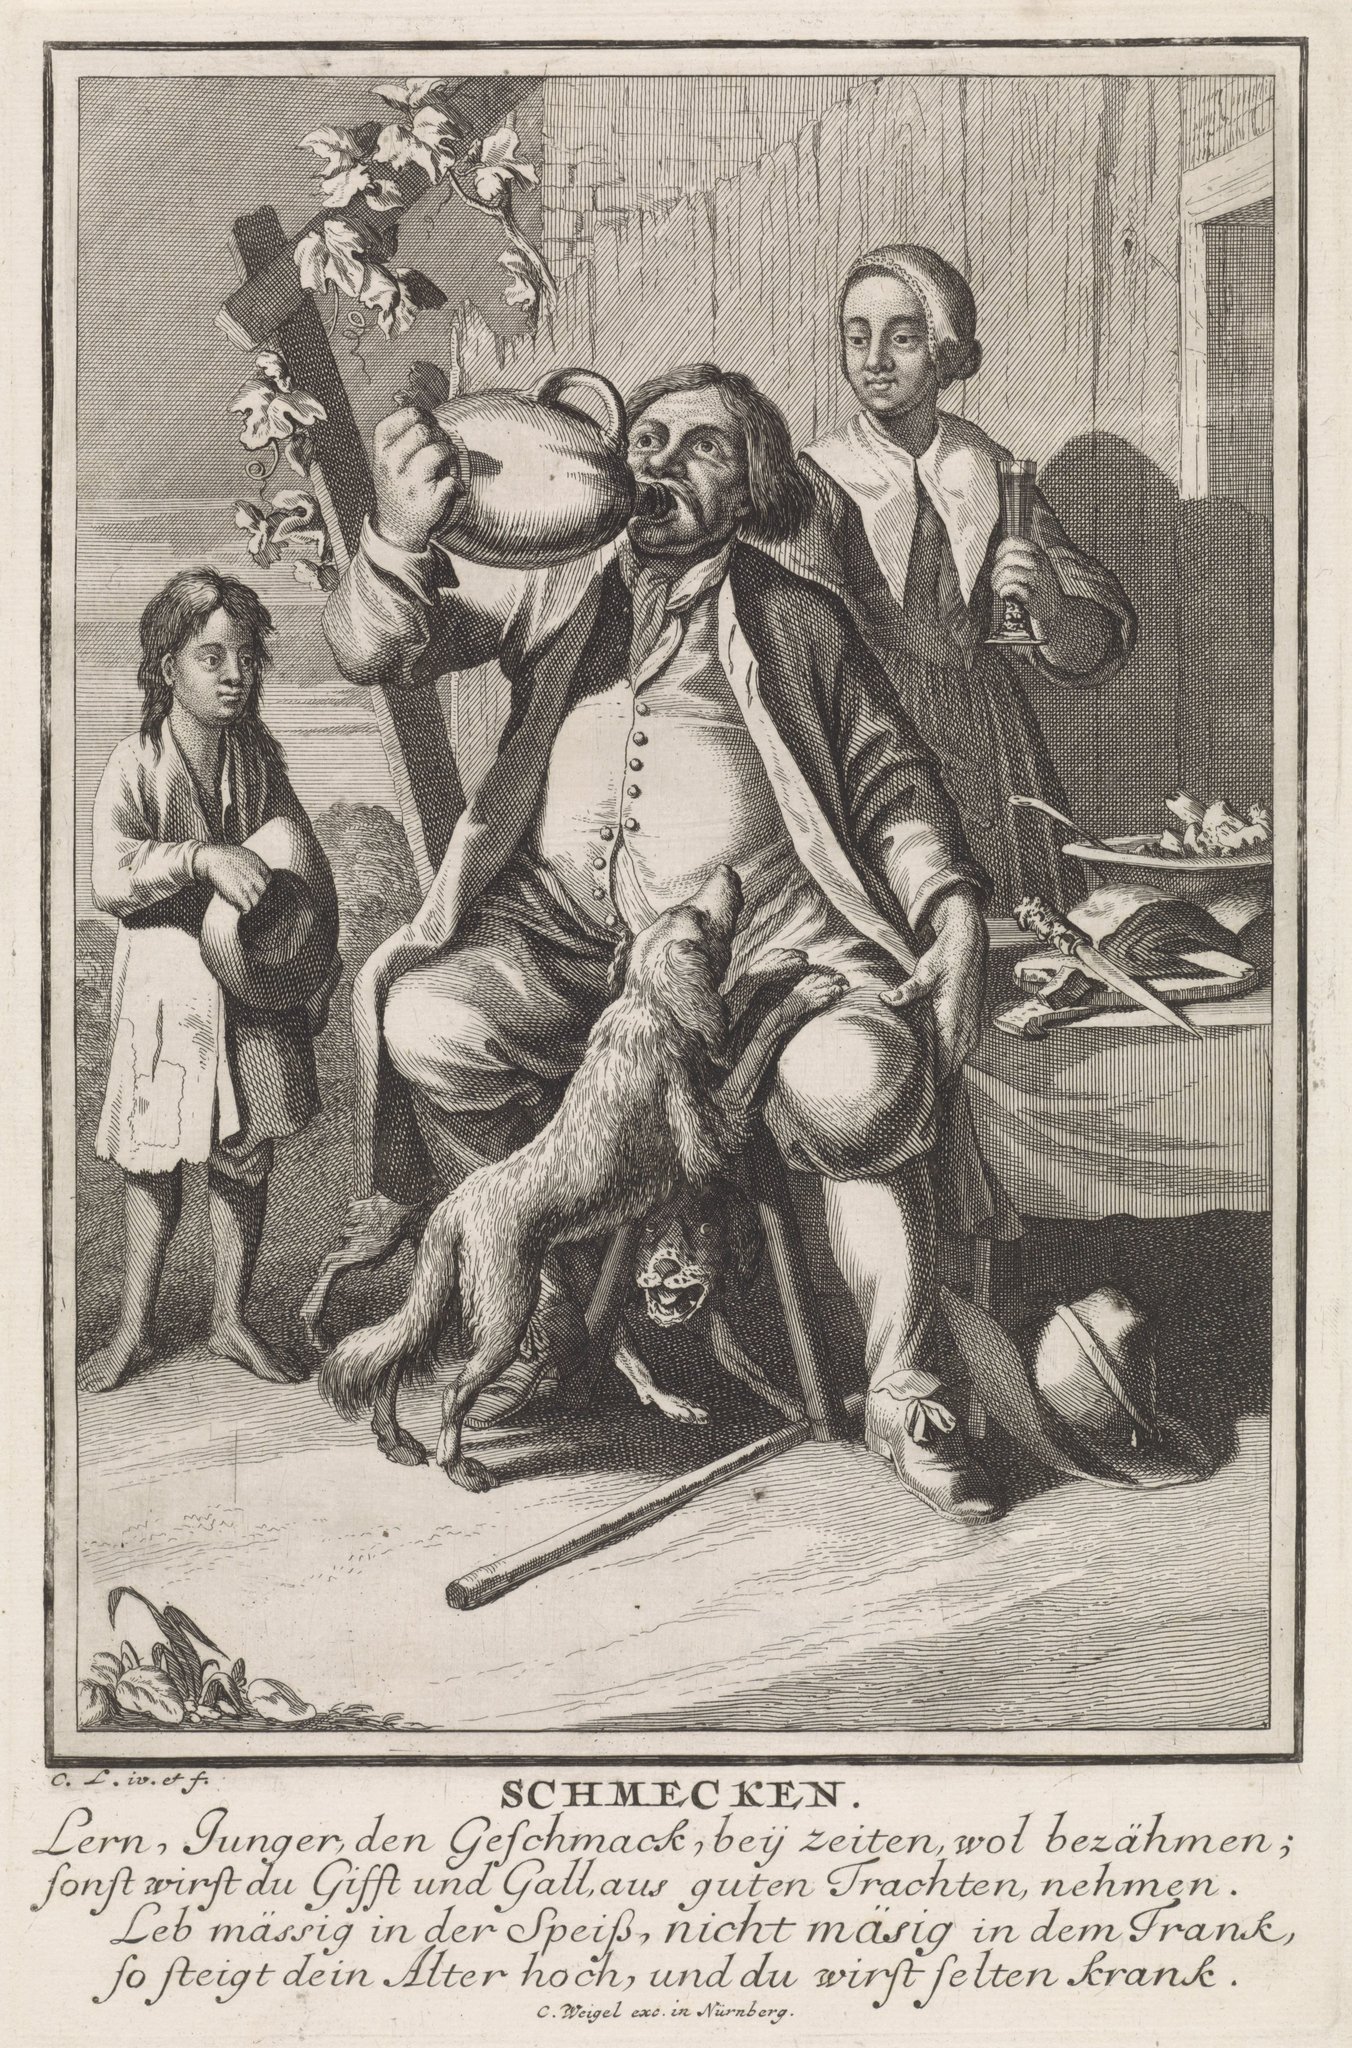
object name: print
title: Smaak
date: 1698-1702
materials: paper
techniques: engraving, etching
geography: nuremberg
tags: midday meal, lunch - cc - out of doors, taste, tasting (one of the five senses), family, relationship, descent, drinking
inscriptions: collector's mark: Lugt 2228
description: Een man zit buiten aan een tafel en drinkt wijn uit een kruik. Rondom hem zijn vrouw en een kind. Op de tafel een stuk beenham. De prent heeft een Duits onderschrift van vier regels over het zintuig smaakzin.